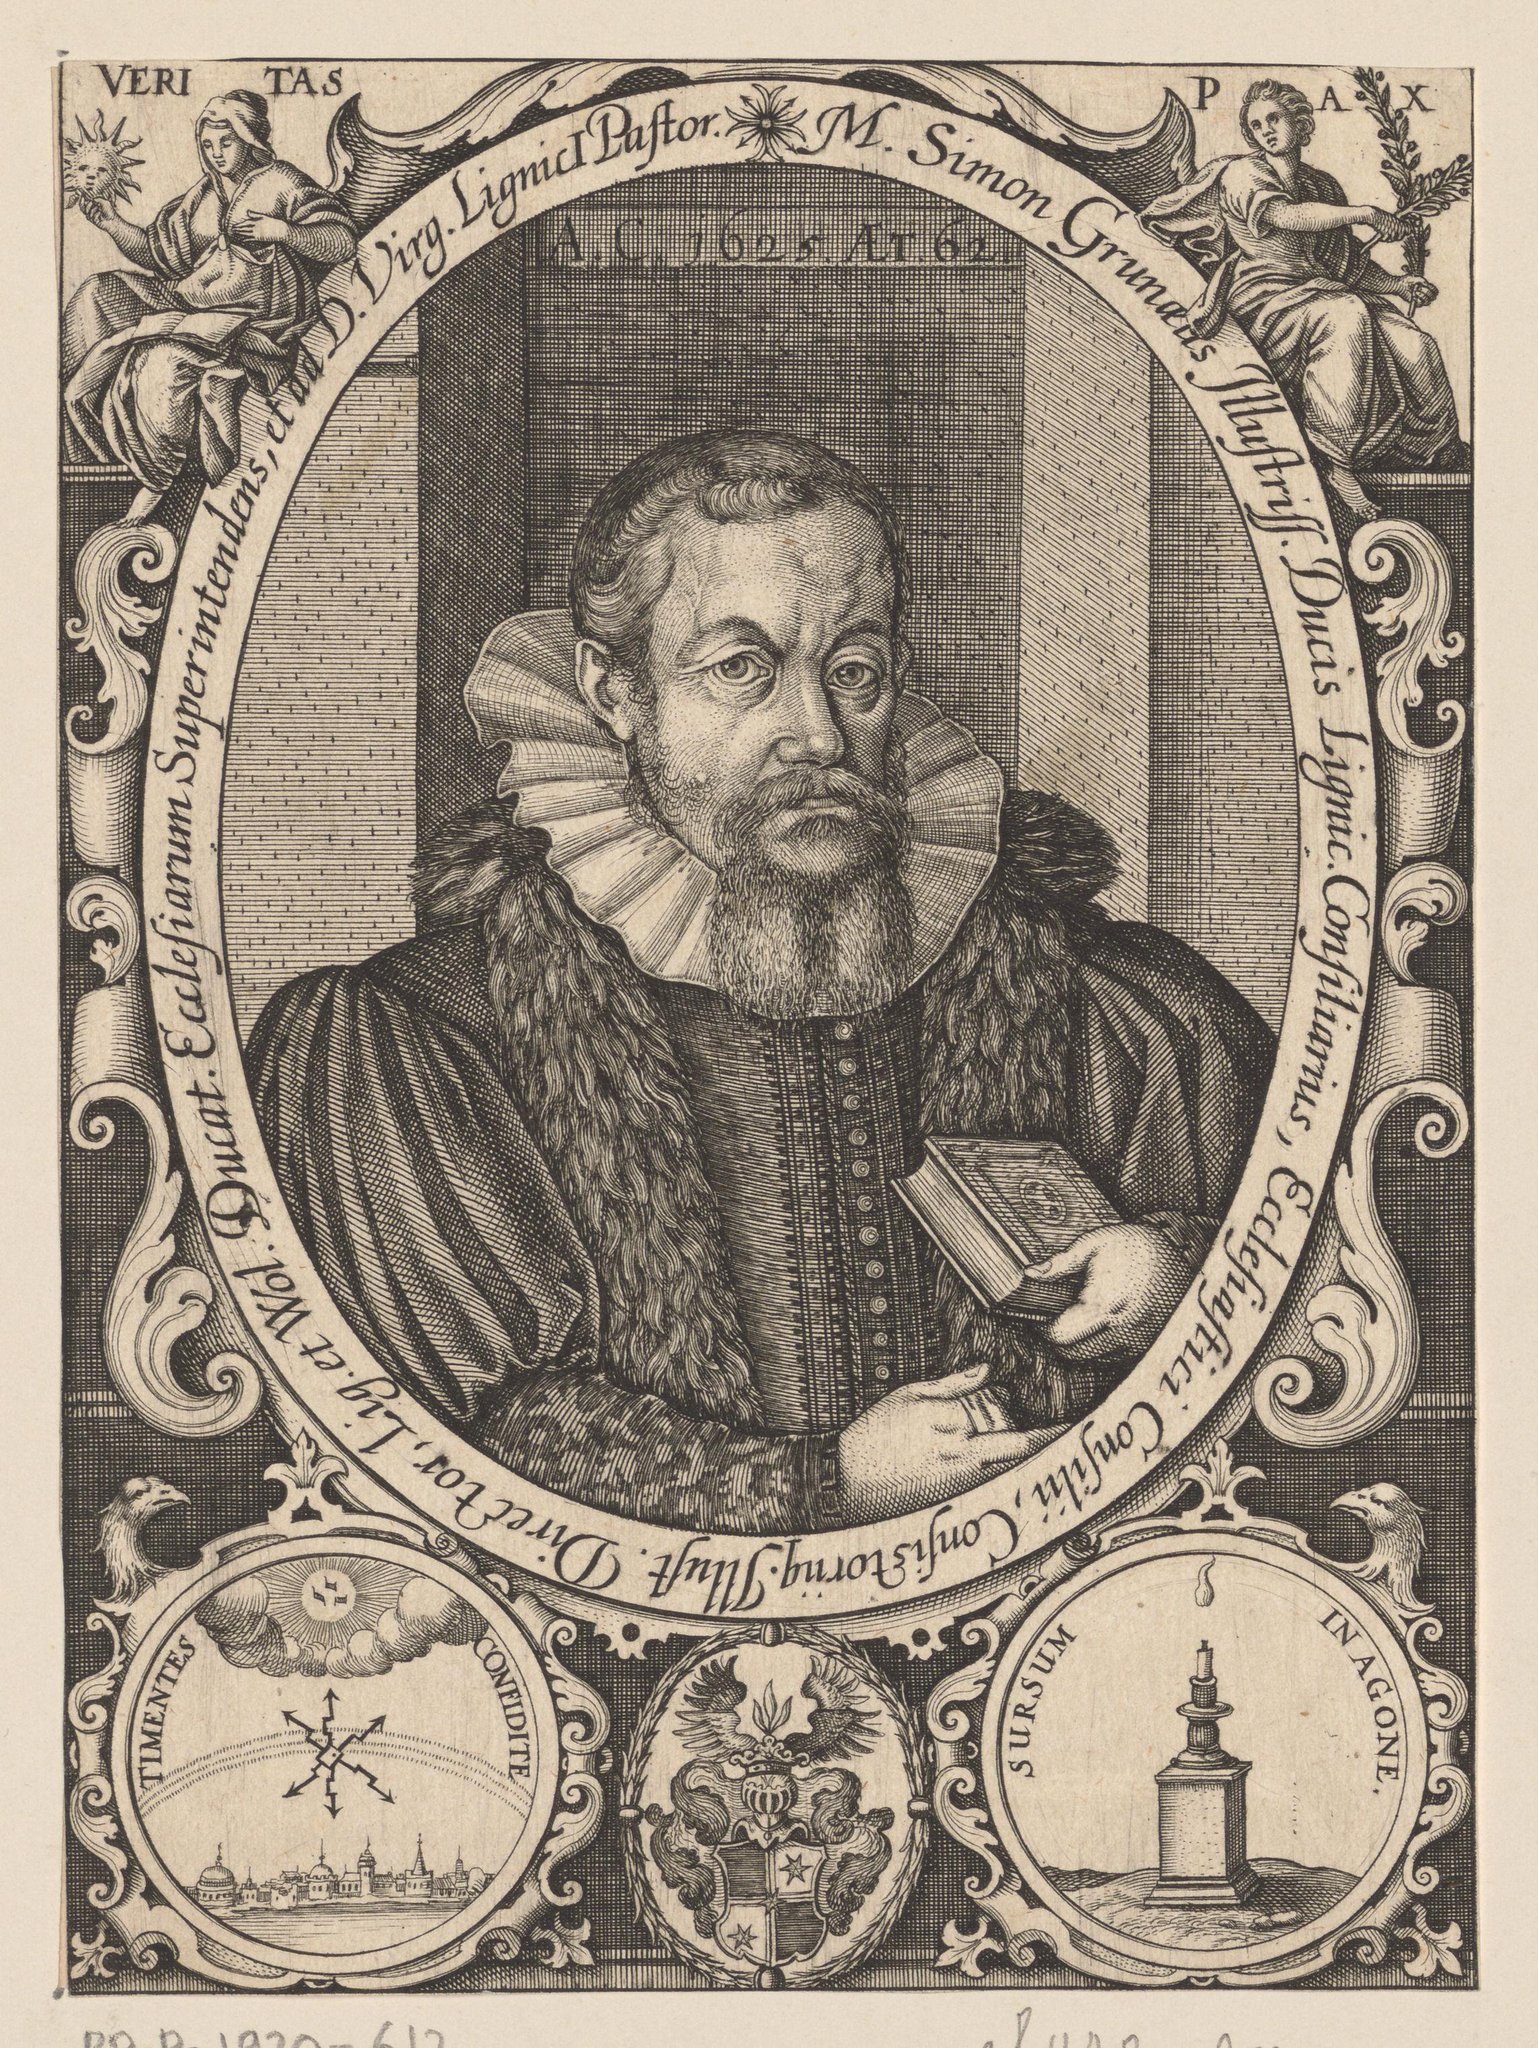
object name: print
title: Portret van Simon Grunaeus op 62-jarige leeftijd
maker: lucas kilian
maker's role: draughtsman, print maker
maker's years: 1579-1637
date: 1625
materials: paper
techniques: engraving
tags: theologian, historical persons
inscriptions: collector's mark: Lugt 2228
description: Tekst in het Latijn in de omlijsting. Twee emblemen in de marge.